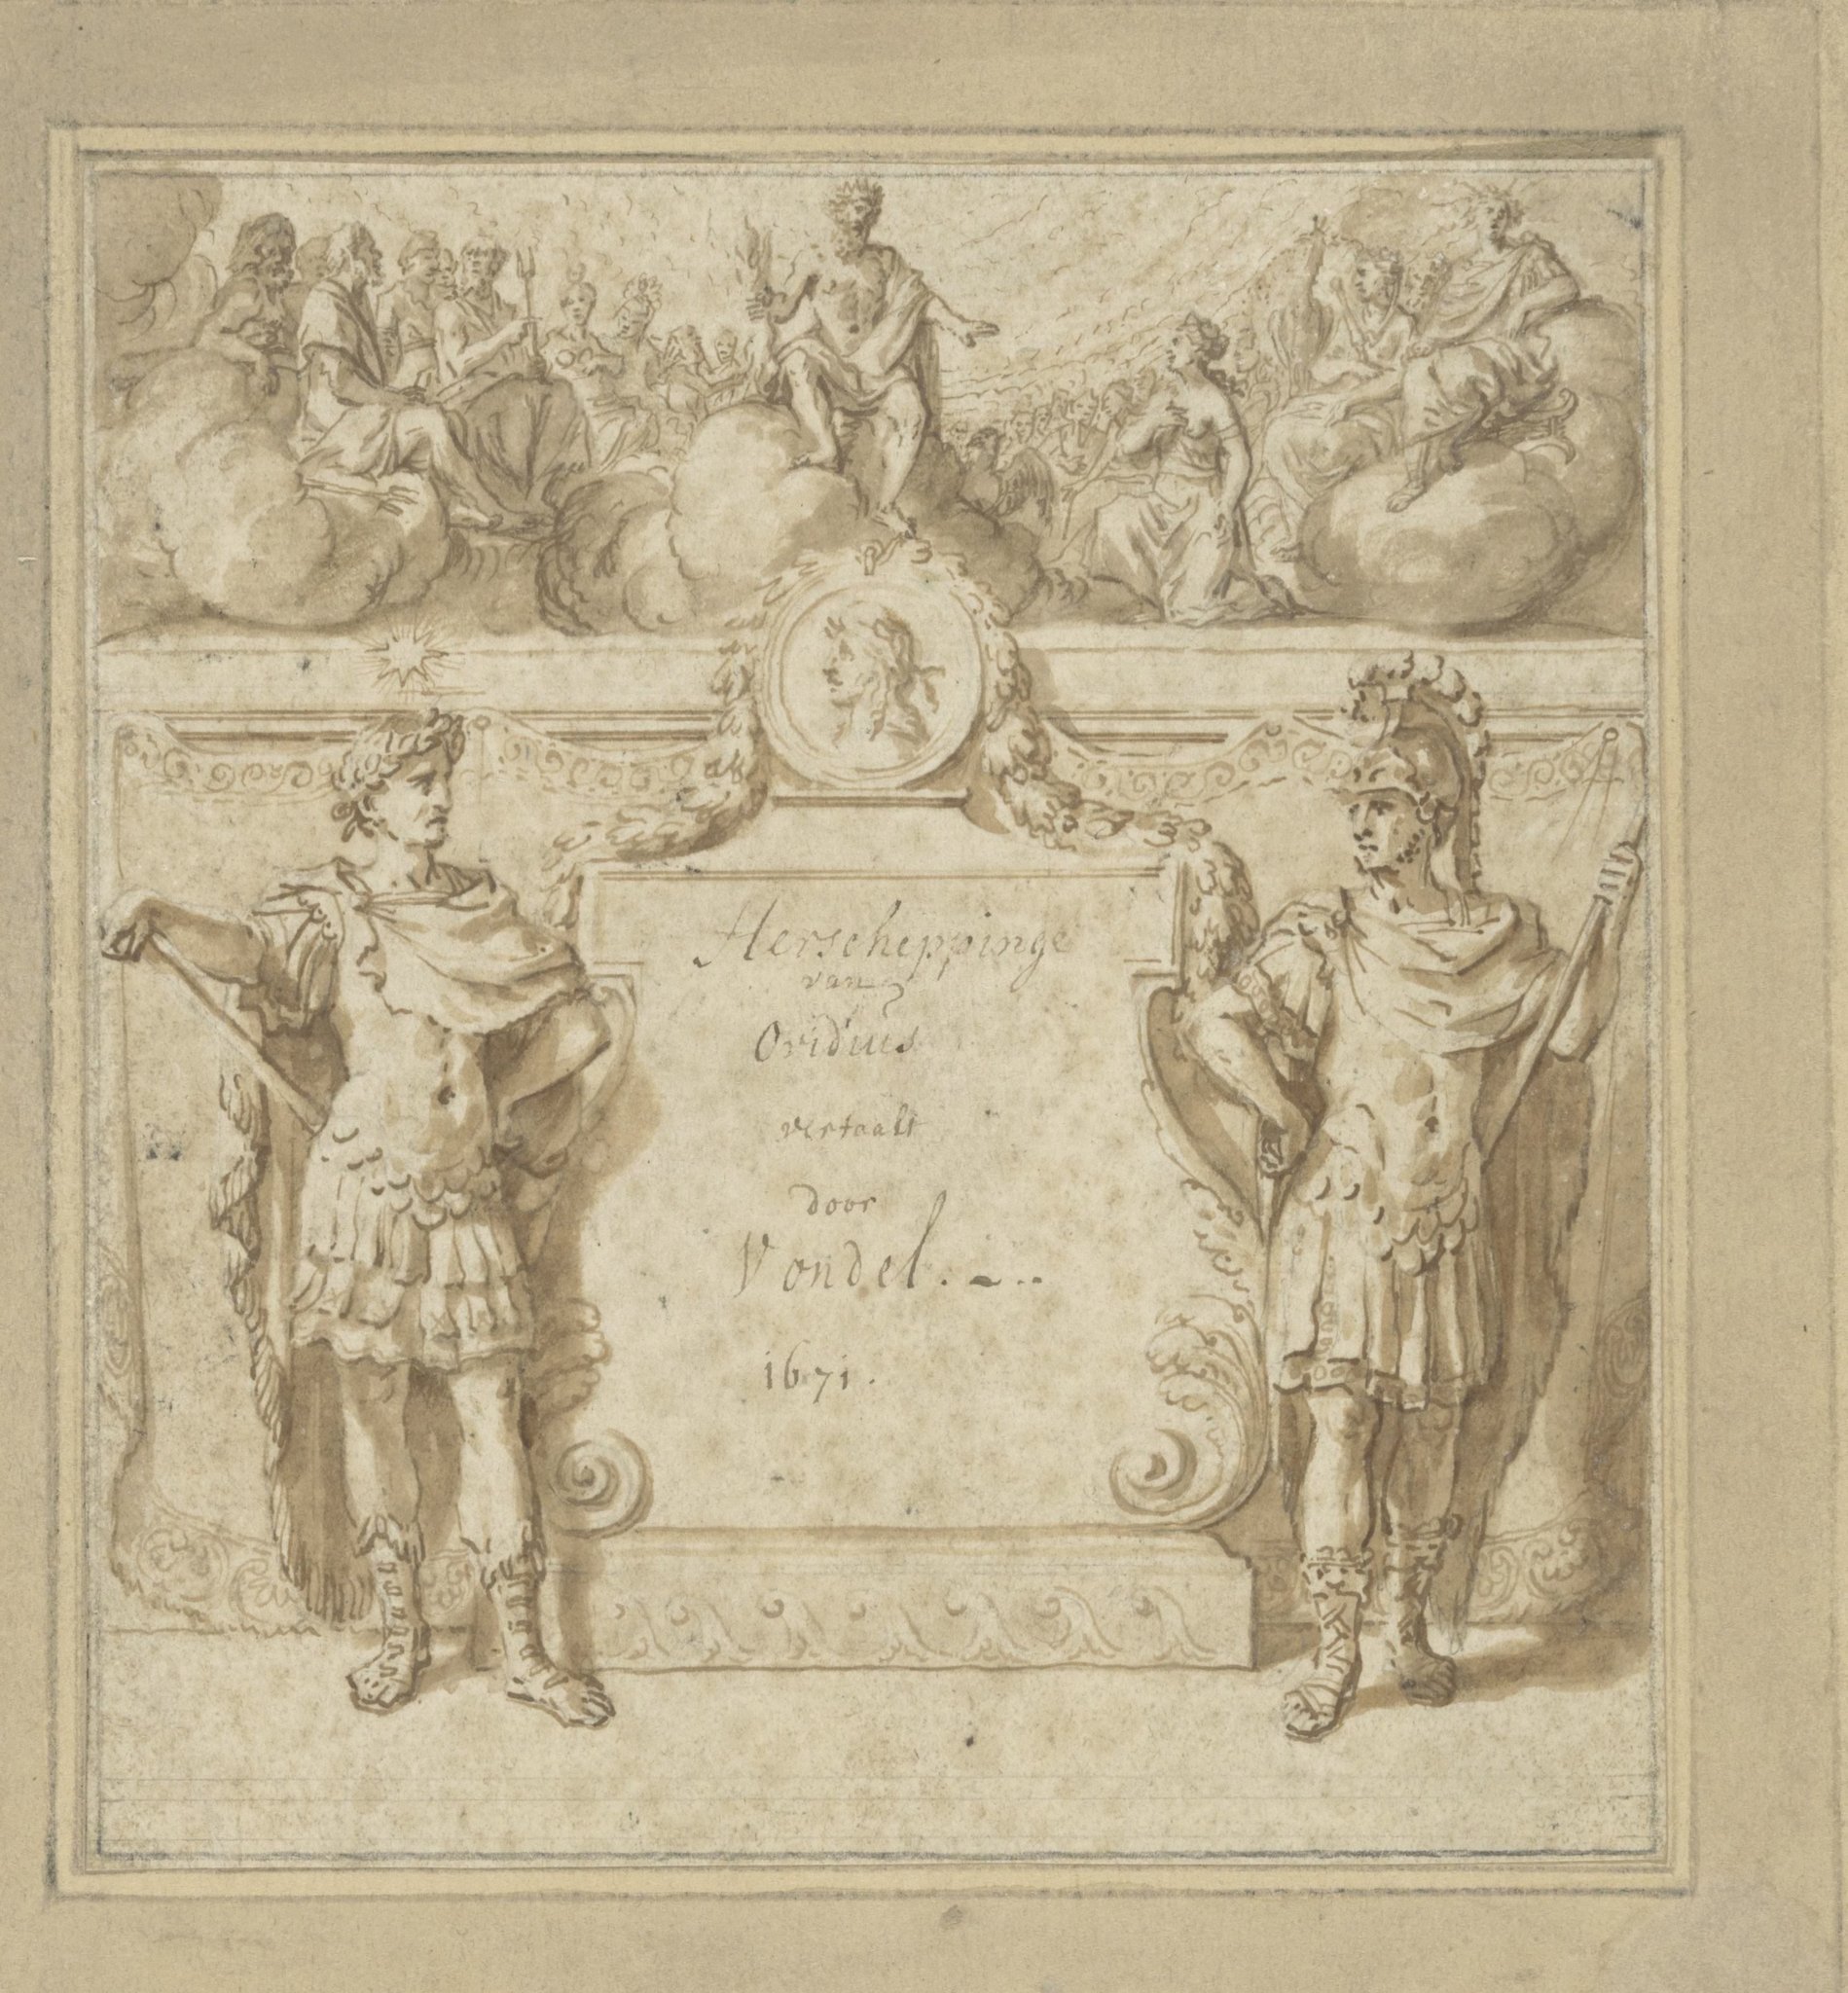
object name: drawing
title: Ontwerp voor de titelpagina van 'Publius Ovidius Nasoos Herscheppinge'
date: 1665-1671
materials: chalk, graphite, ink, paper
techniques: brush, pen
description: Ontwerp voor het titelpagina van Publius Ovidius Naso's Herscheppinge in de vertaling van Joost van de Vondel, 1671.